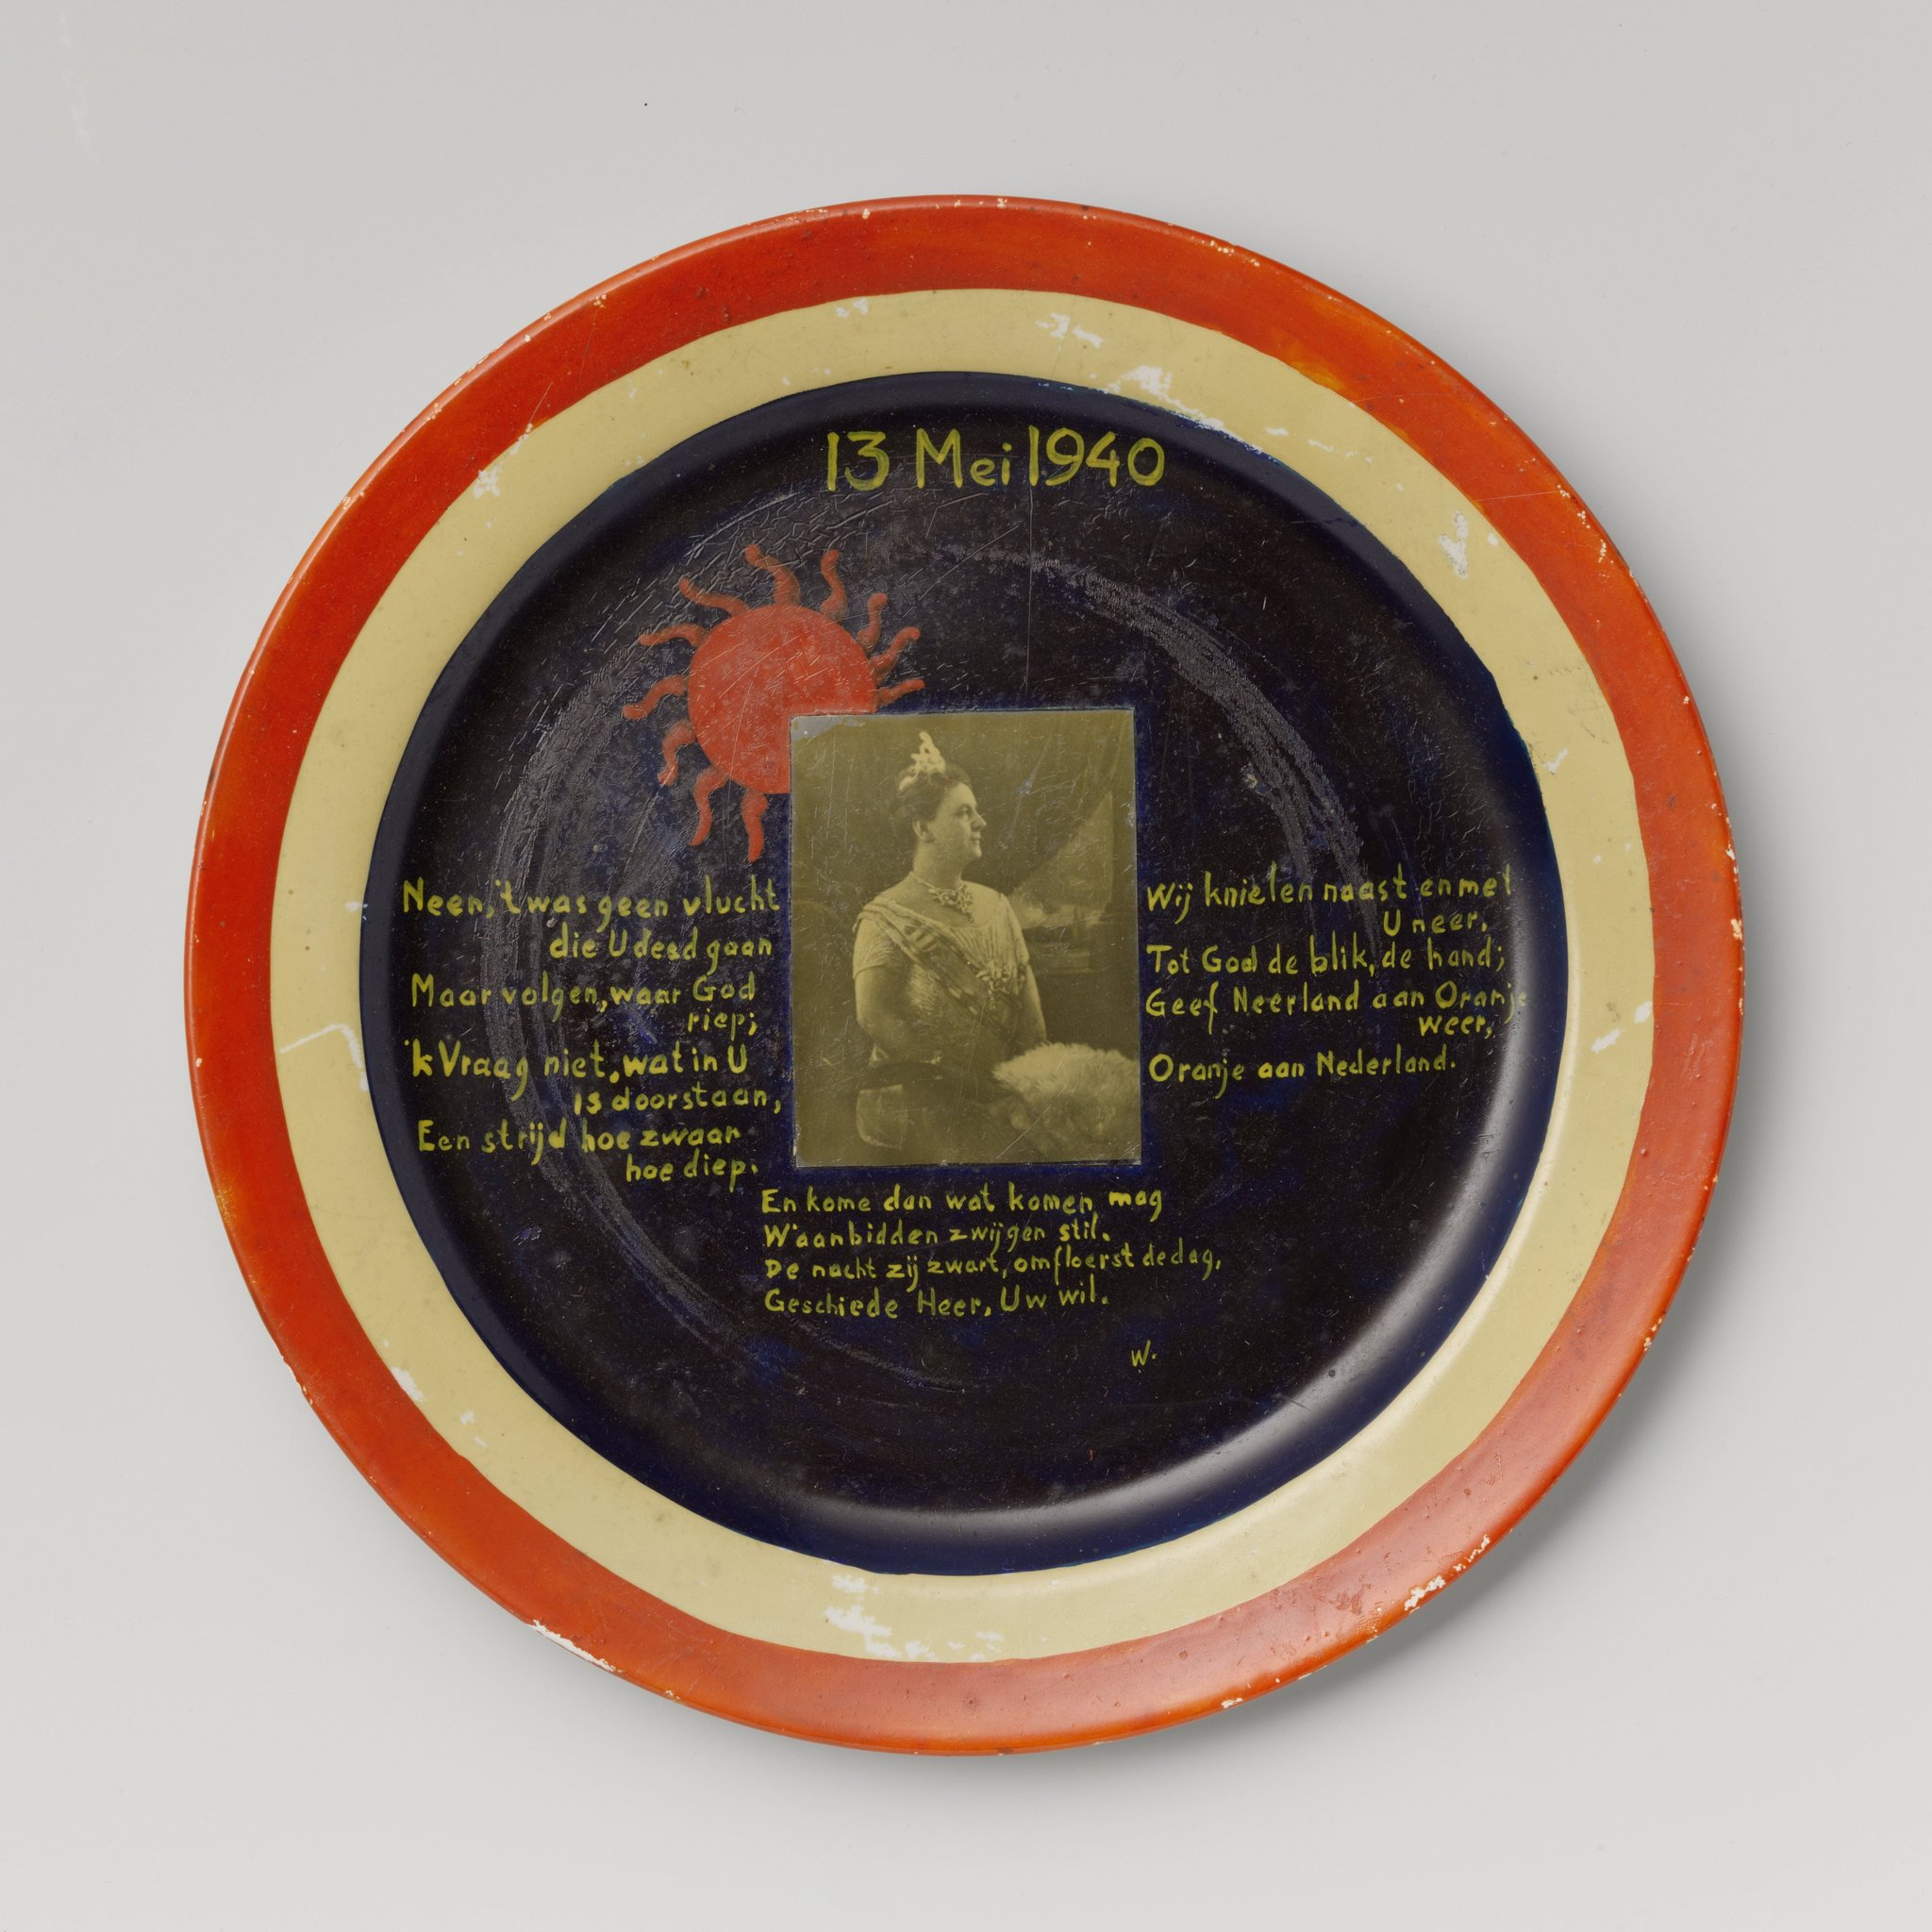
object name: plate dish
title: Bord met portret van koningin Wilhelmina (13 mei 1940) en tekst (door 'W.')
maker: Anonymous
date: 1940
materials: paper, ceramic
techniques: gelatin silver print